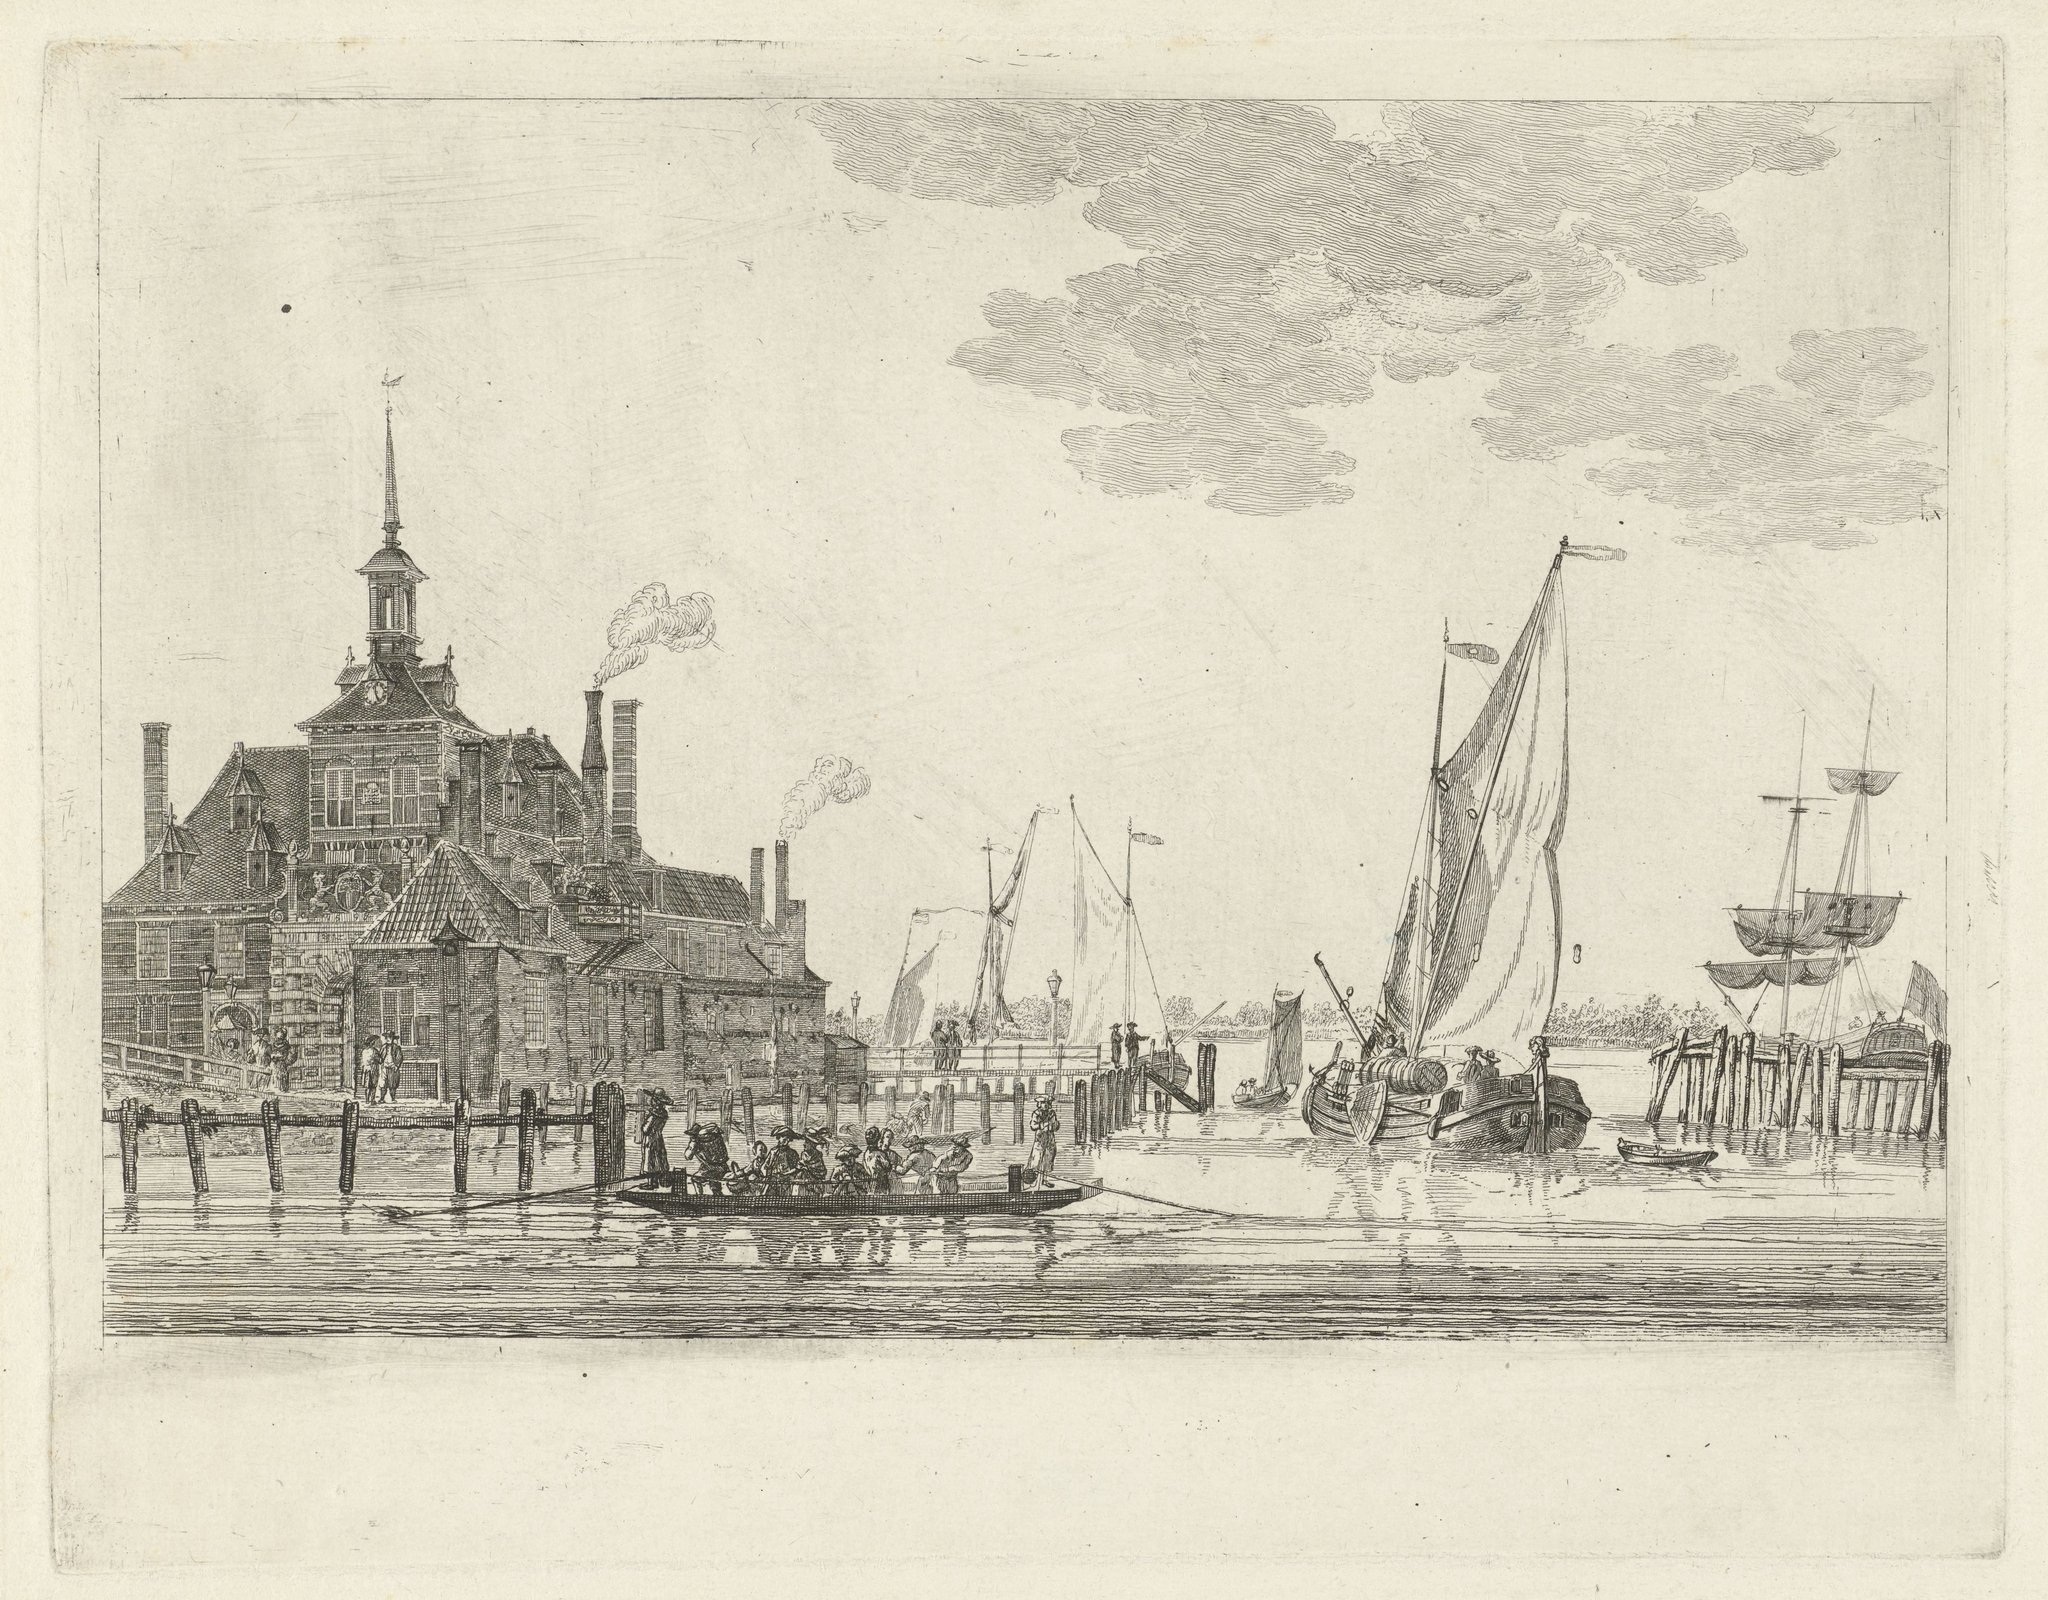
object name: print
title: Oude Hoofdpoort te Rotterdam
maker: gerrit groenewegen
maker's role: draughtsman, print maker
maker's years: 1754-1826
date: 1764-1826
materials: paper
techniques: etching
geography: rotterdam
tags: harbour, sailing-ship, sailing-boat, rowing-boat, canoe, etc. (+ track, trail of an animal), rotterdam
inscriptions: collector's mark: Lugt 2228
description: Gezicht op het Ooster Oude Hoofdpoort te Rotterdam met op de voorgrond een veerpont en een aantal zeilschepen.